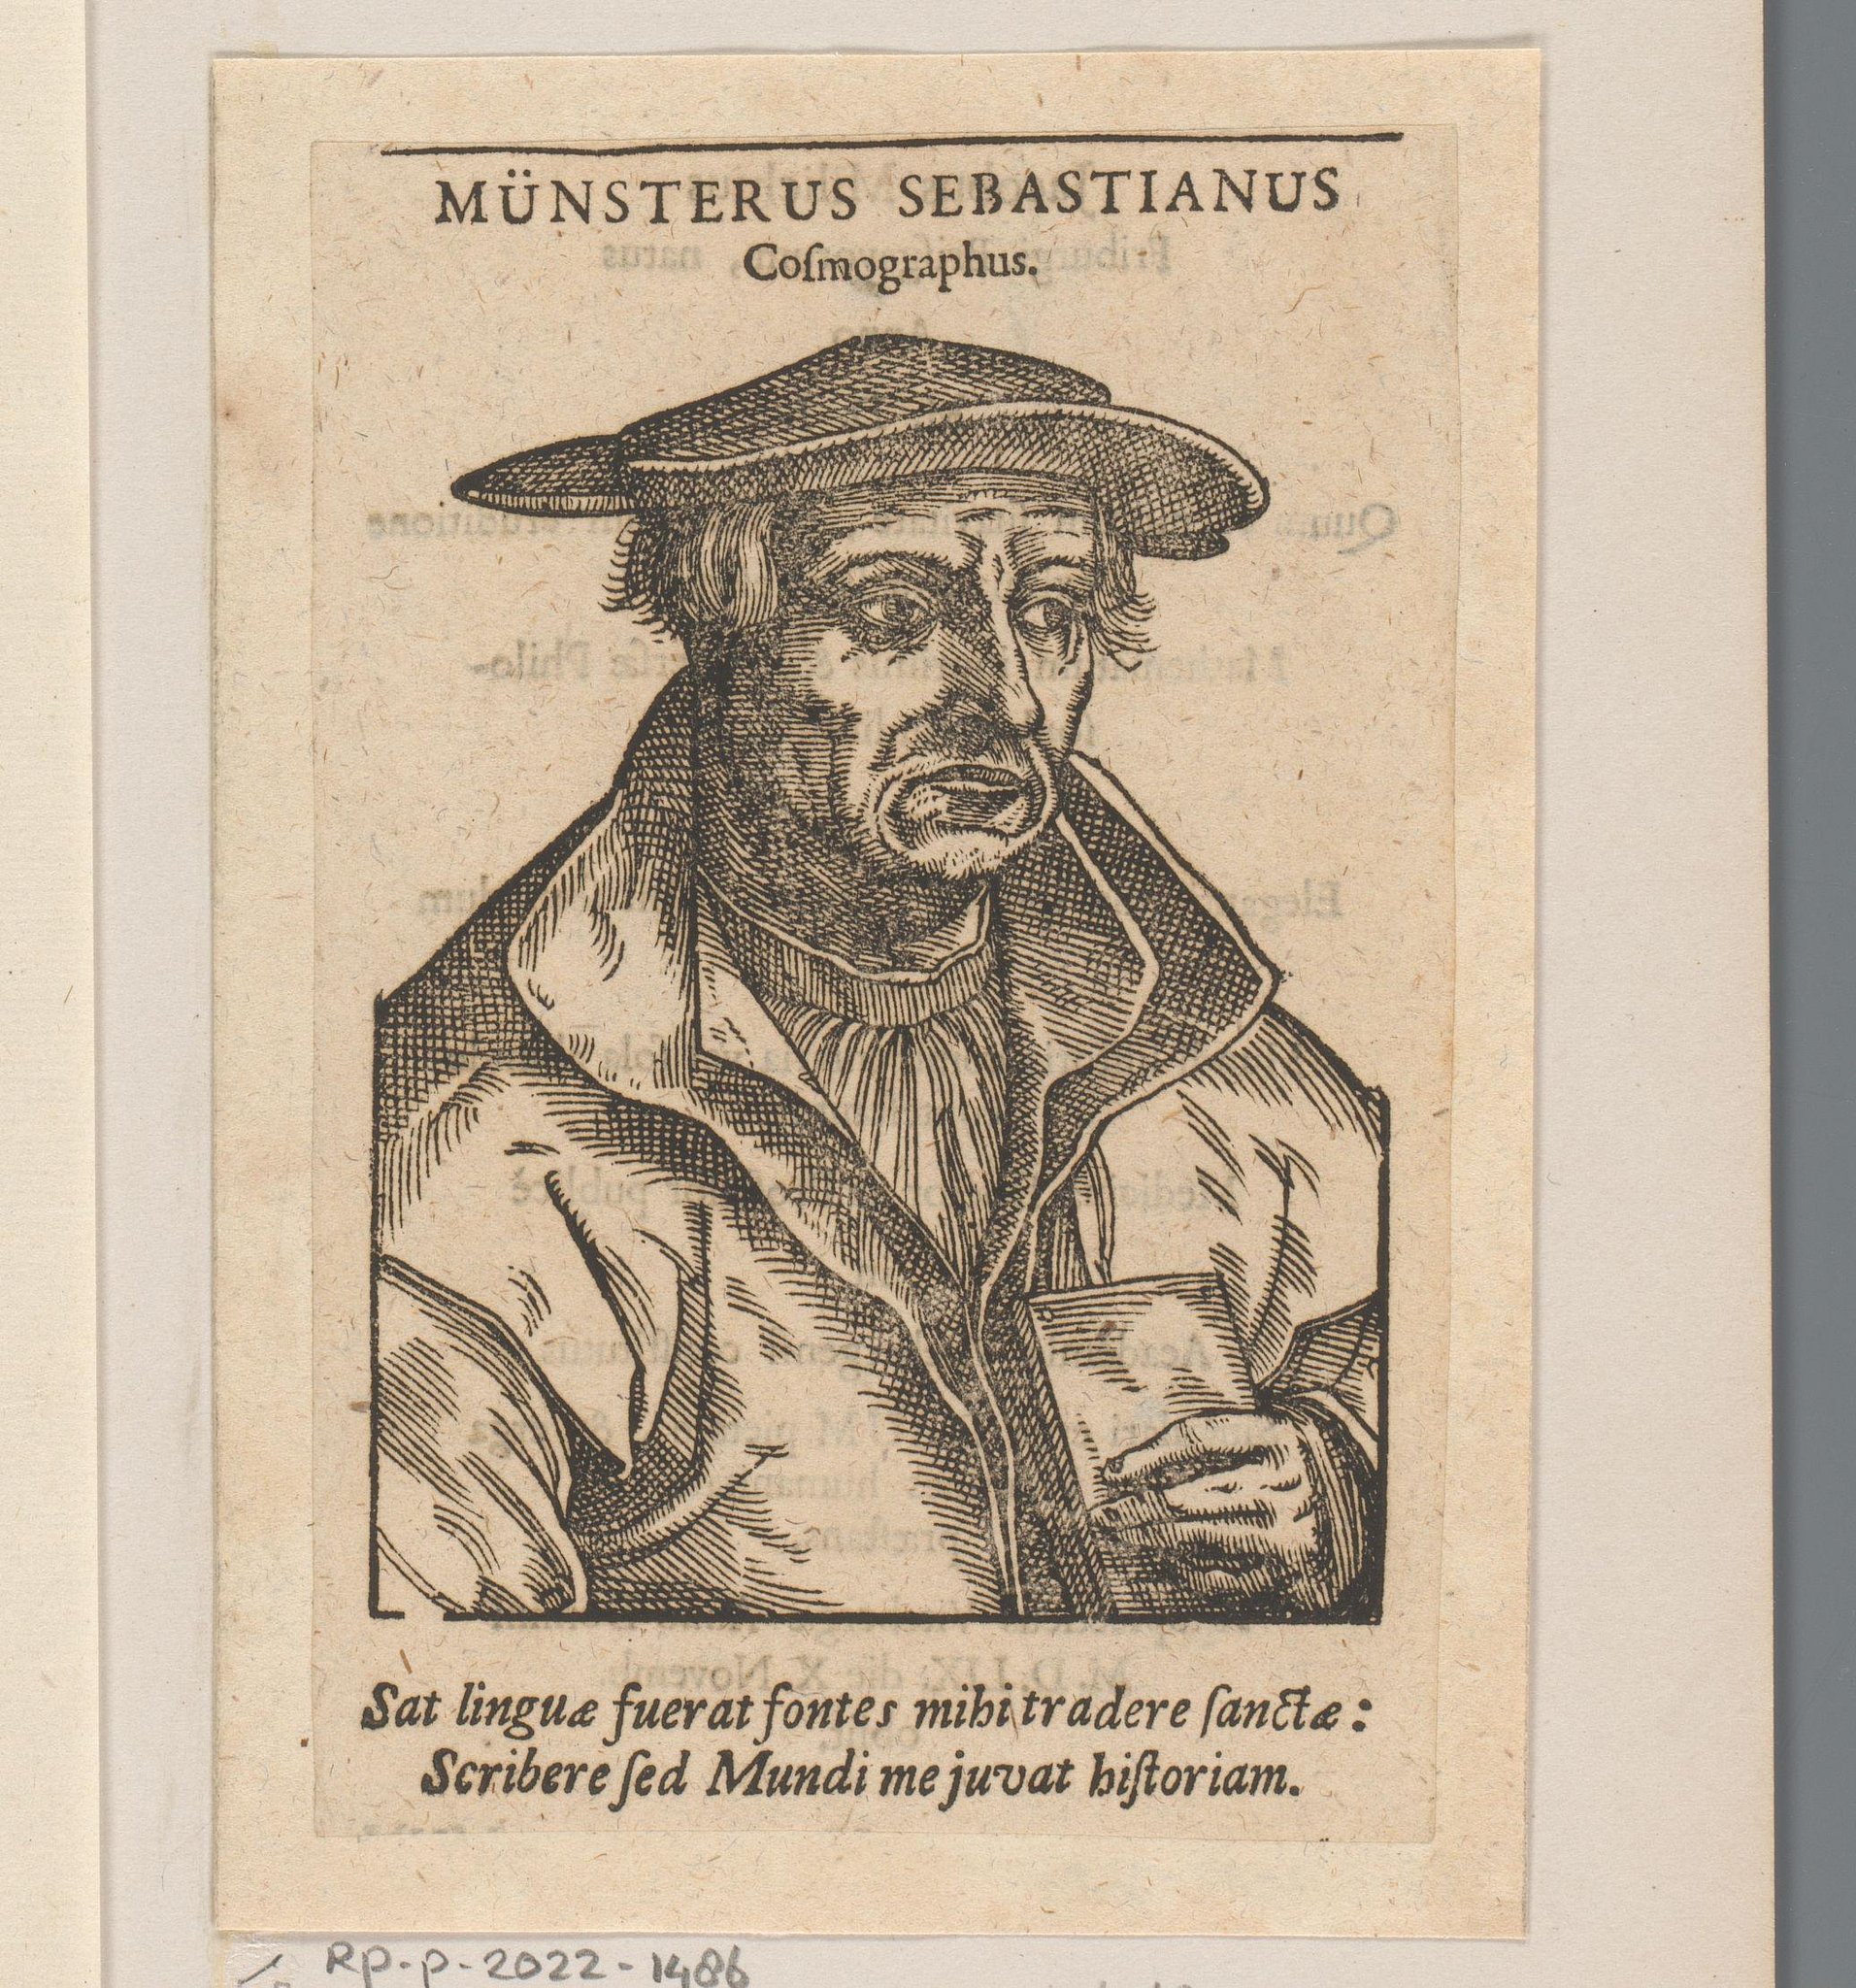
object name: print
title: Portret van Sebastian Münster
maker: tobias stimmer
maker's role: draughtsman, painter, print maker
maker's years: 1539-1584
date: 1540-1650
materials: paper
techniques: letterpress printing, snipping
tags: scholar, philosopher, historical persons